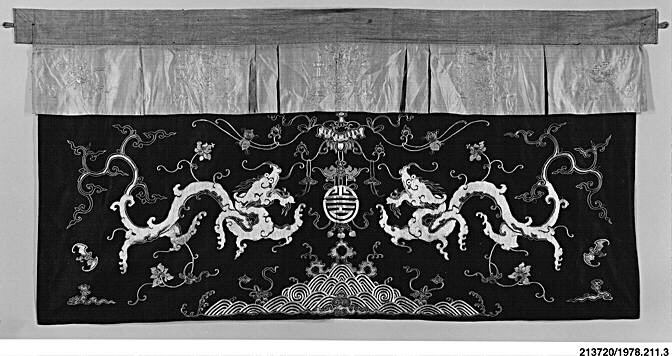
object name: valance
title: Valance for Table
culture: chinese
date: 1701-1800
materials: metal thread, silk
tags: dragons